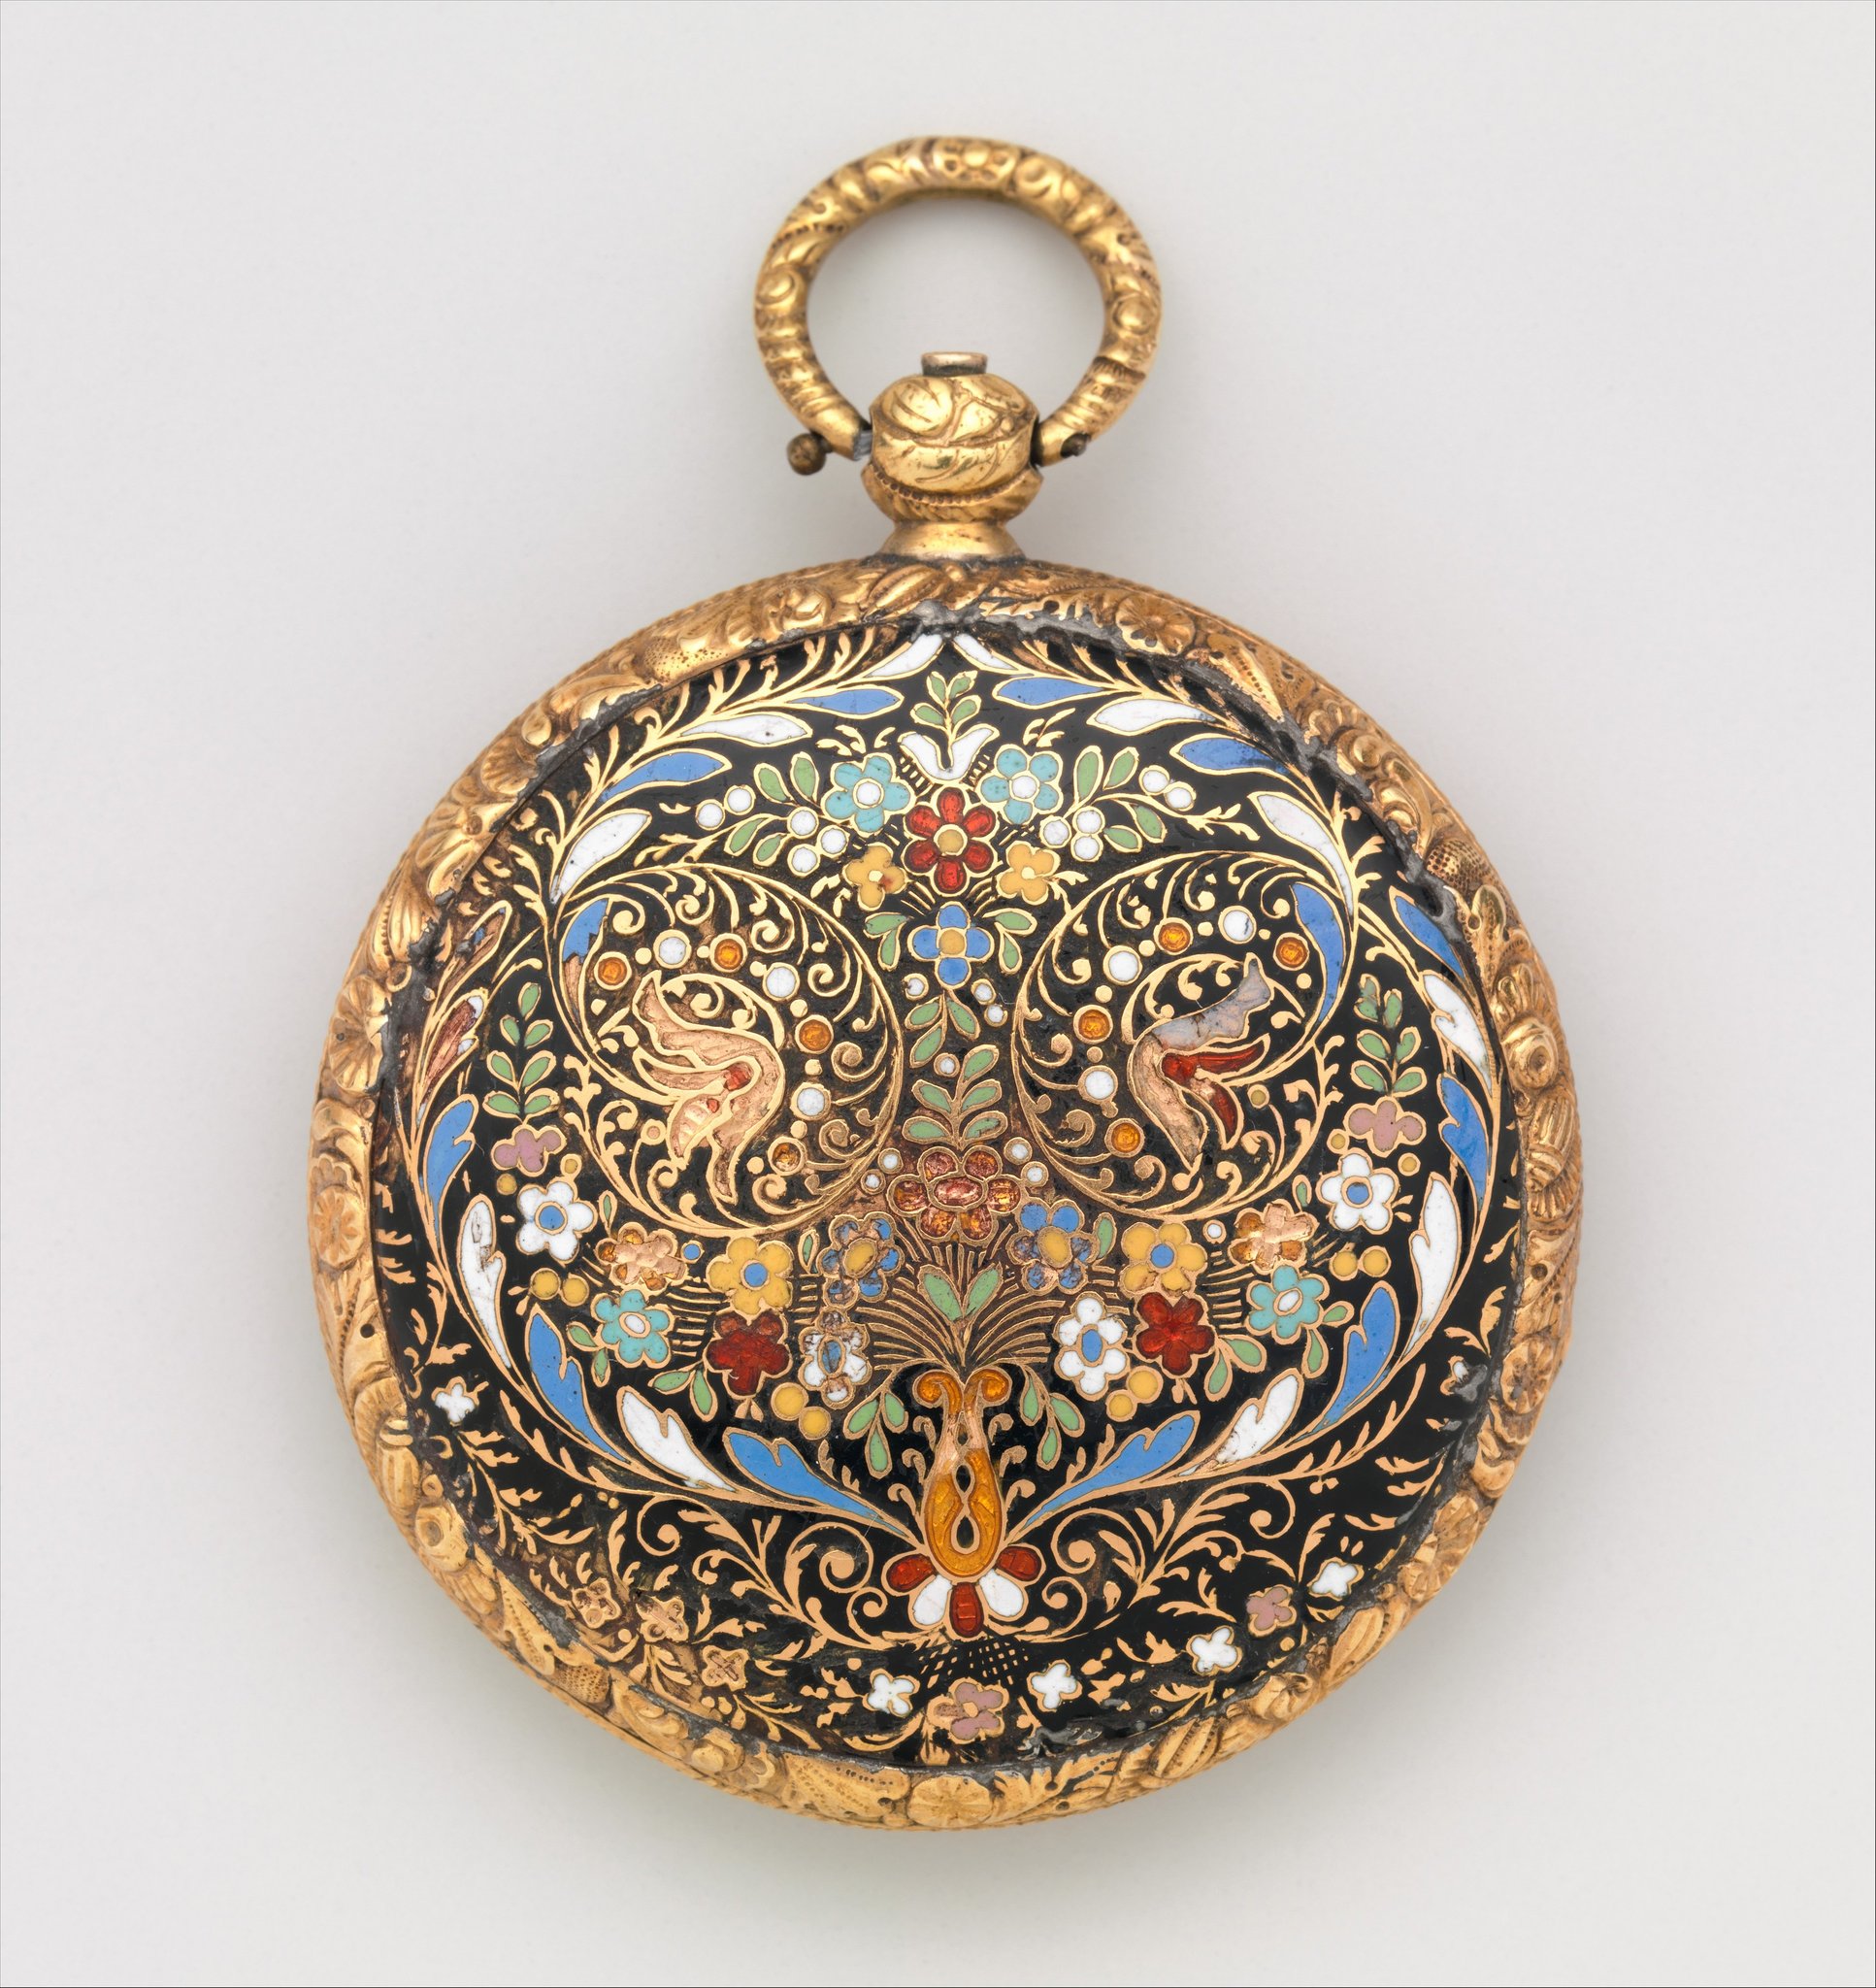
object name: watch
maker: pierre morel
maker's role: maker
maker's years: 1775-1840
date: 1820-1835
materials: enamel, gold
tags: flowers